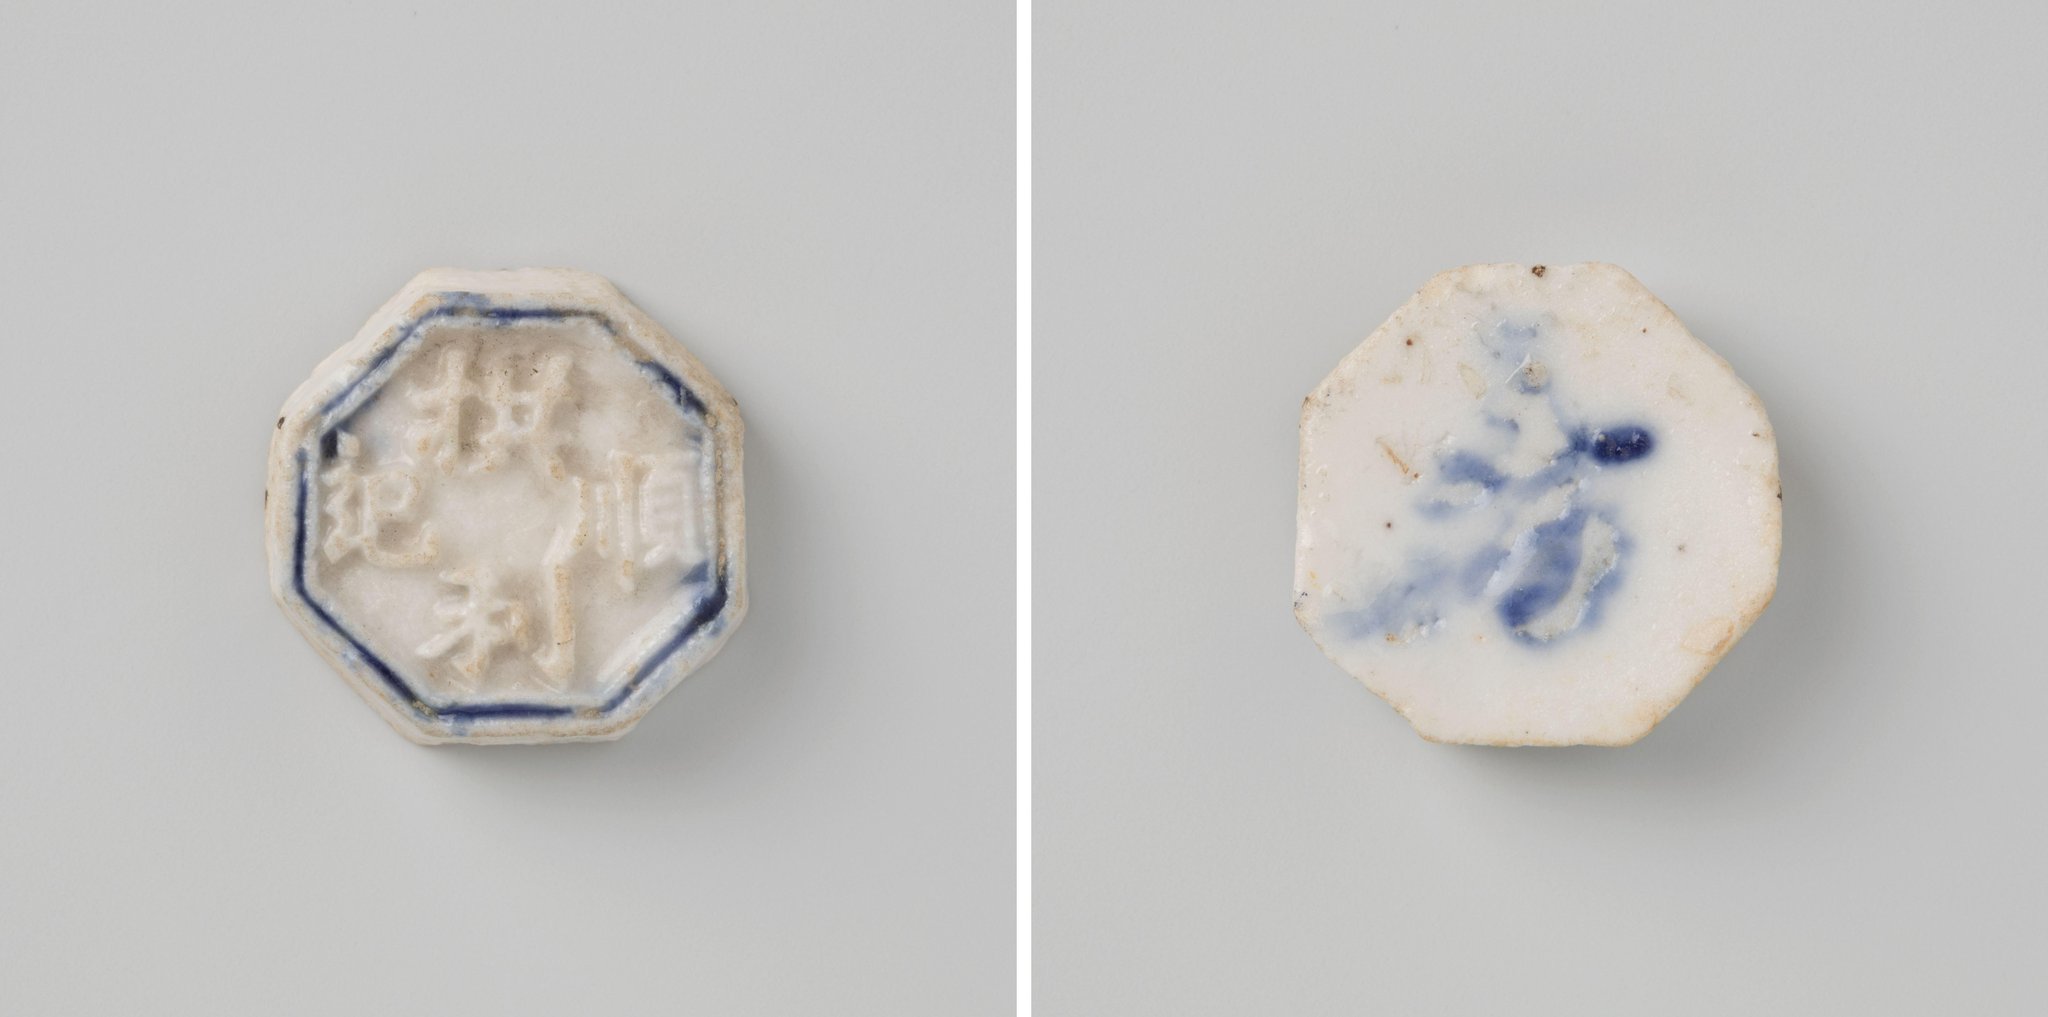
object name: coin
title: Speelhuispenning uit Thailand, 1760-1871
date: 1760-1871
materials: porcelain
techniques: firing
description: Achthoekige porseleinen speelhuispenning, die ook als munt is gebruikt. Voorzijde: vier Chinese karakters. Keerzijde: een Chinees karakter of versiering.